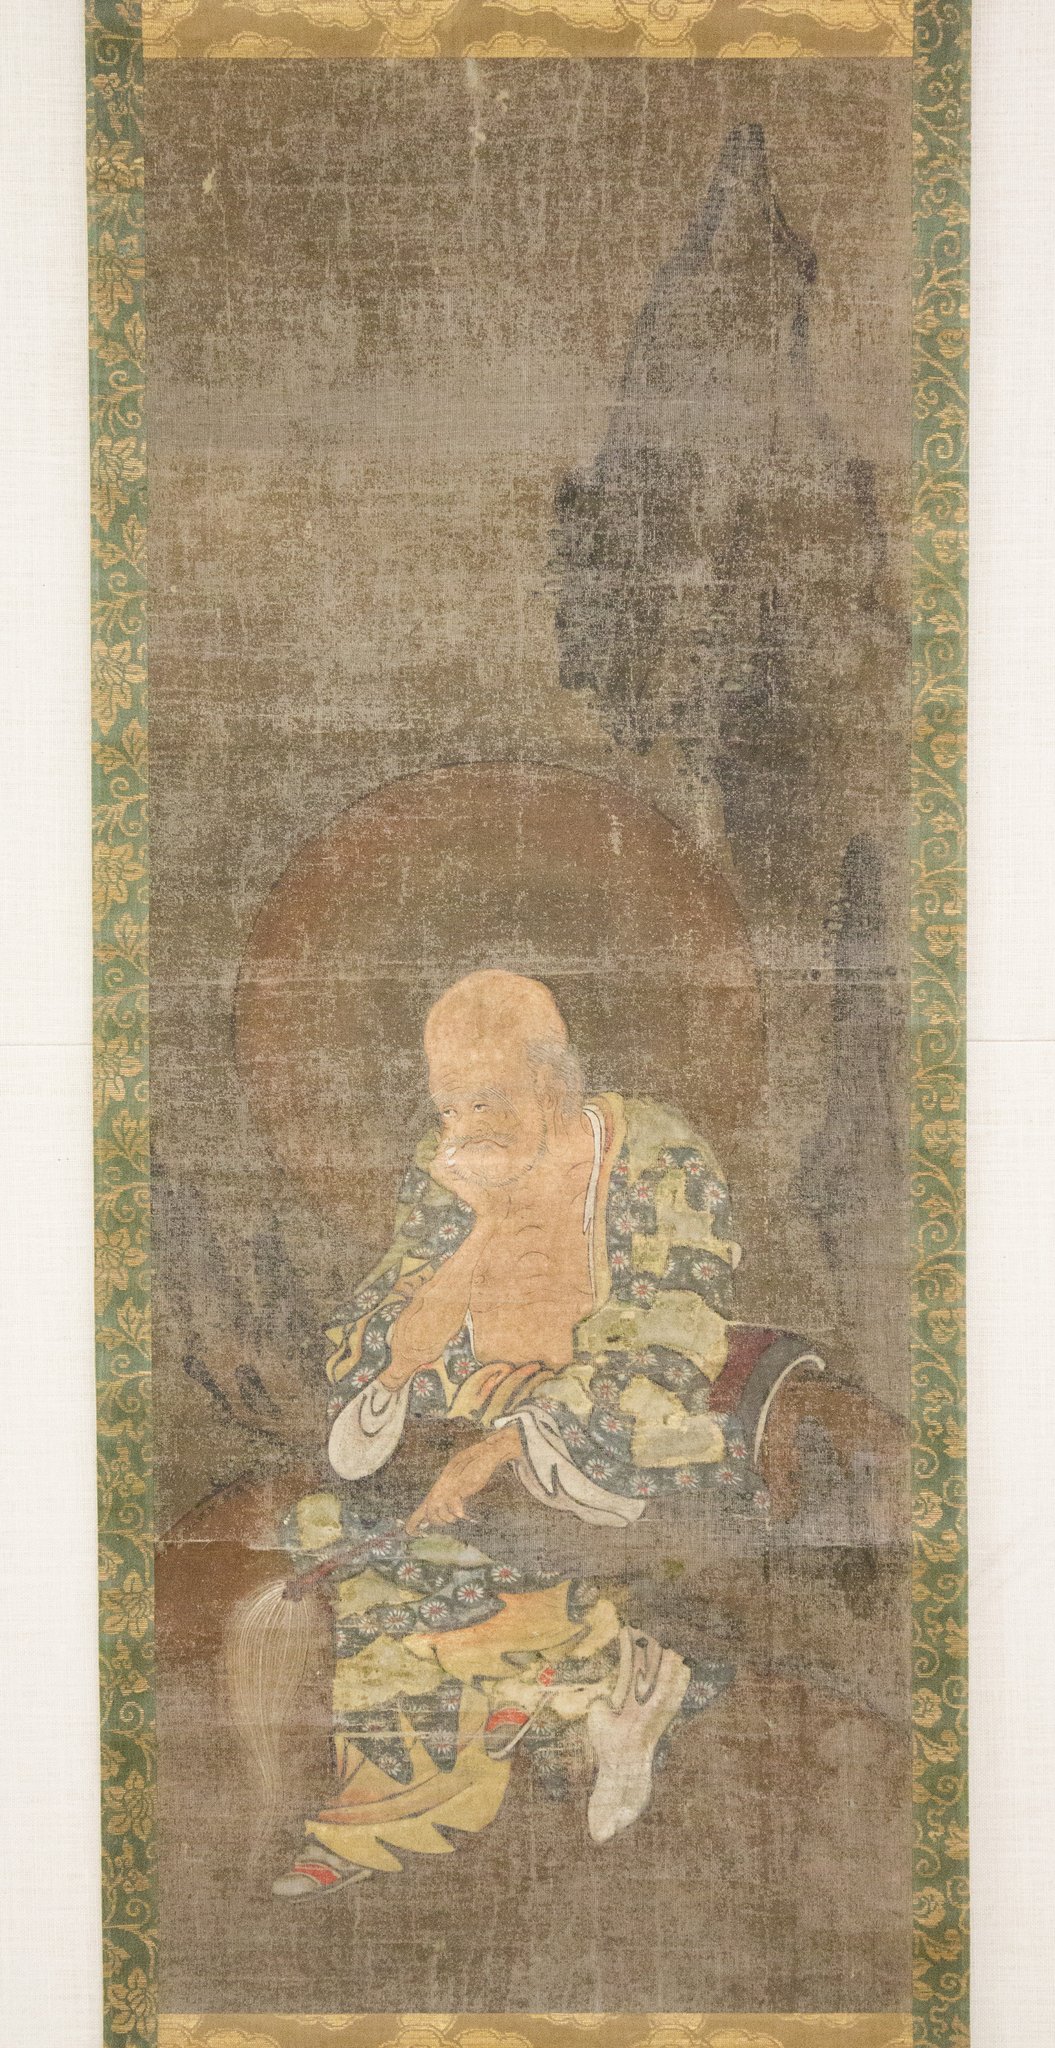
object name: hanging scroll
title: Rakan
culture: japanese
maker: keinin sumiyoshi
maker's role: artist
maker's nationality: japanese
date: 1401-1500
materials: ink, silk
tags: men